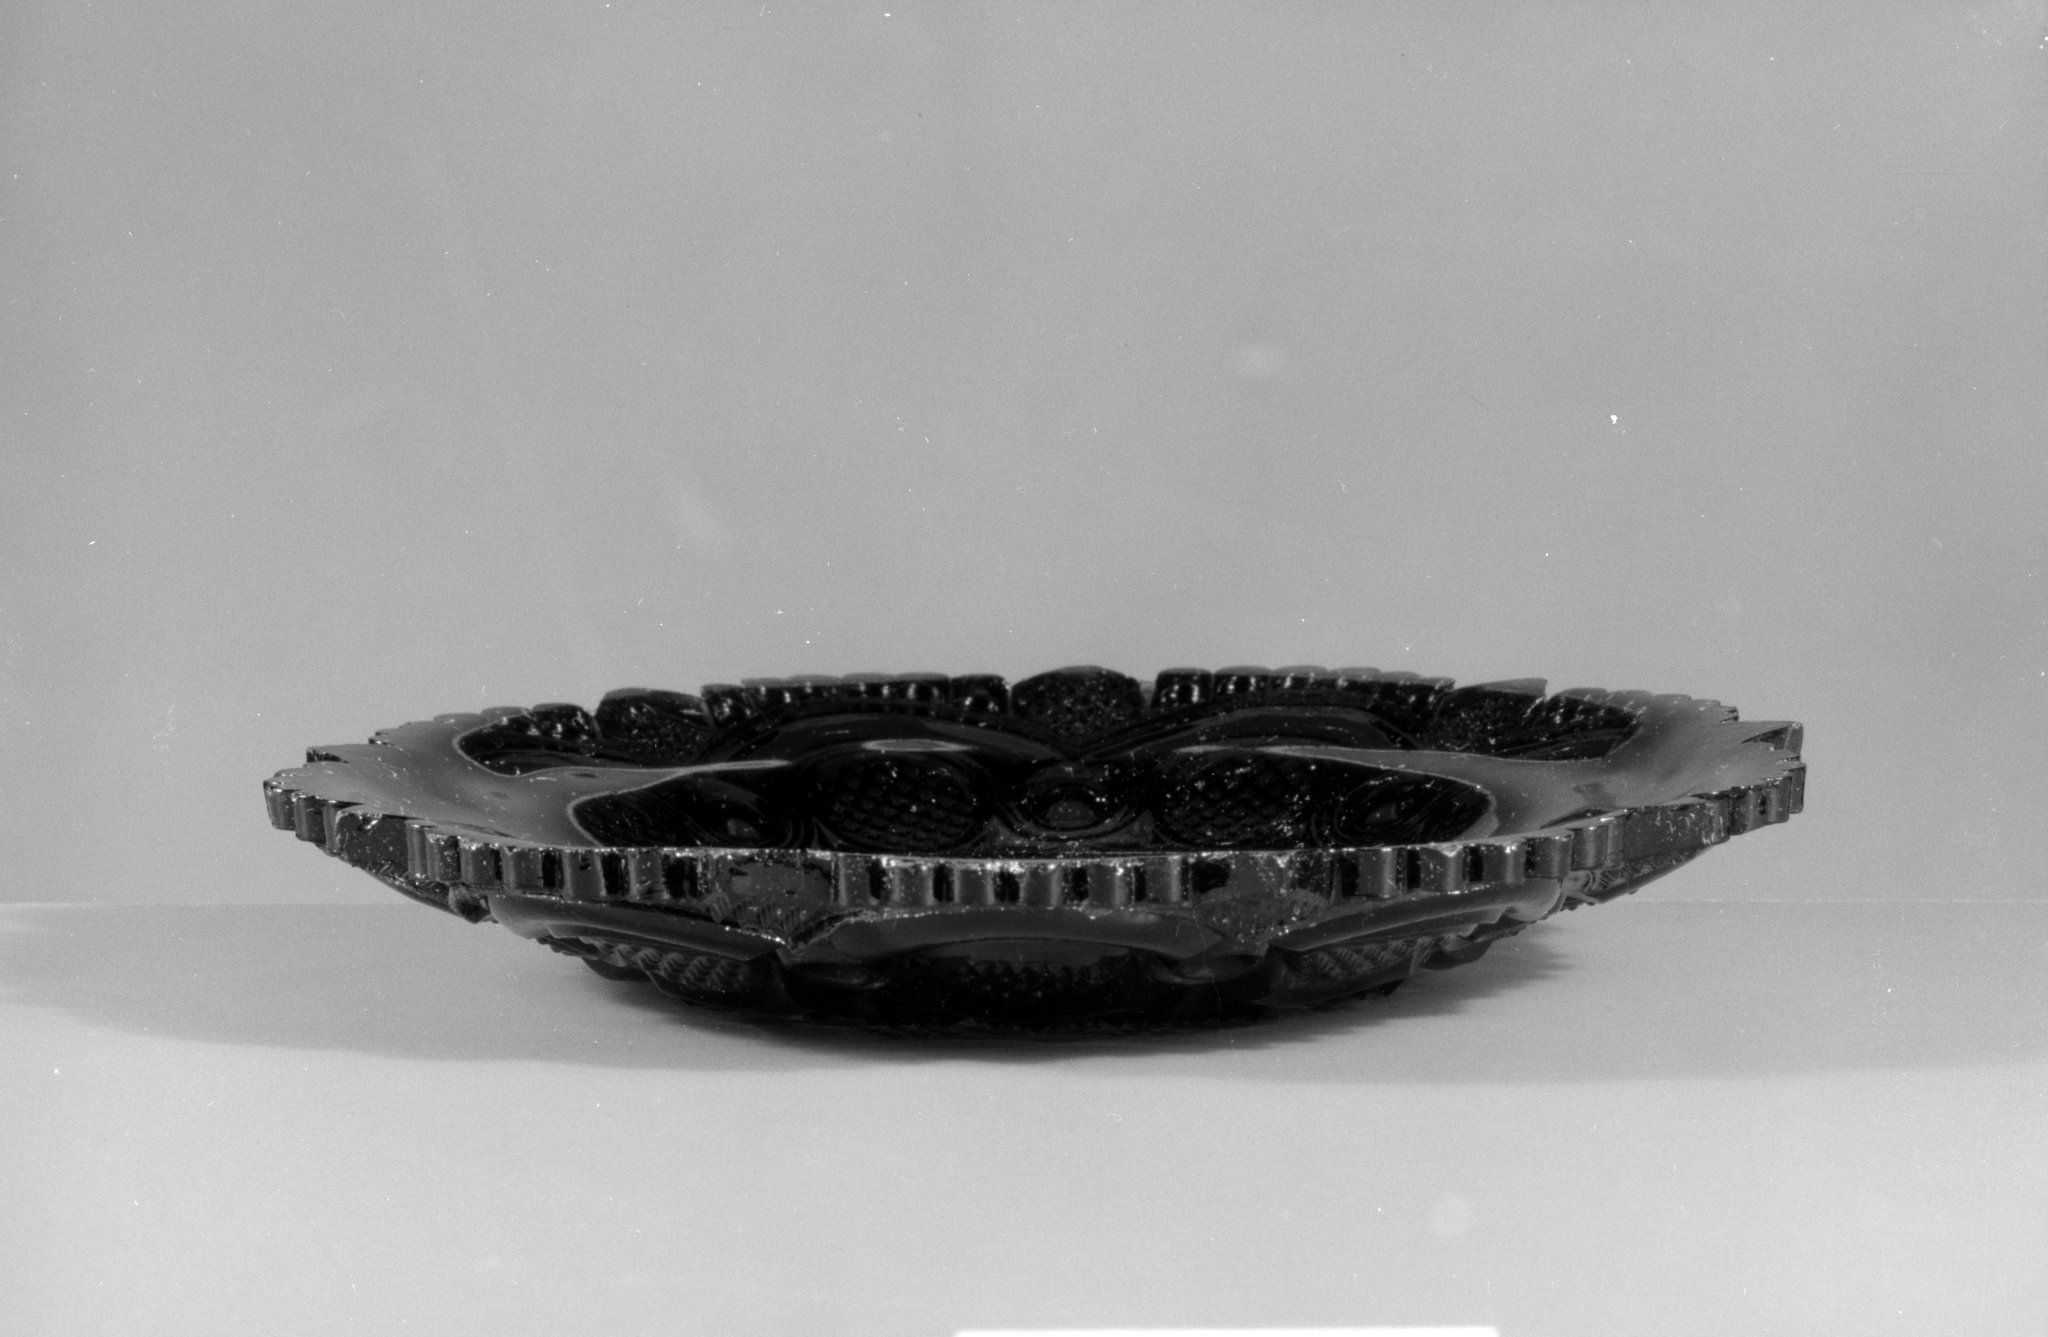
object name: dish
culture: american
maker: boston & sandwich glass company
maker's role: maker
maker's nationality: american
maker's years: 1825-1888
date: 1835-1840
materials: gemstone, glass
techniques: pressed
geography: united states